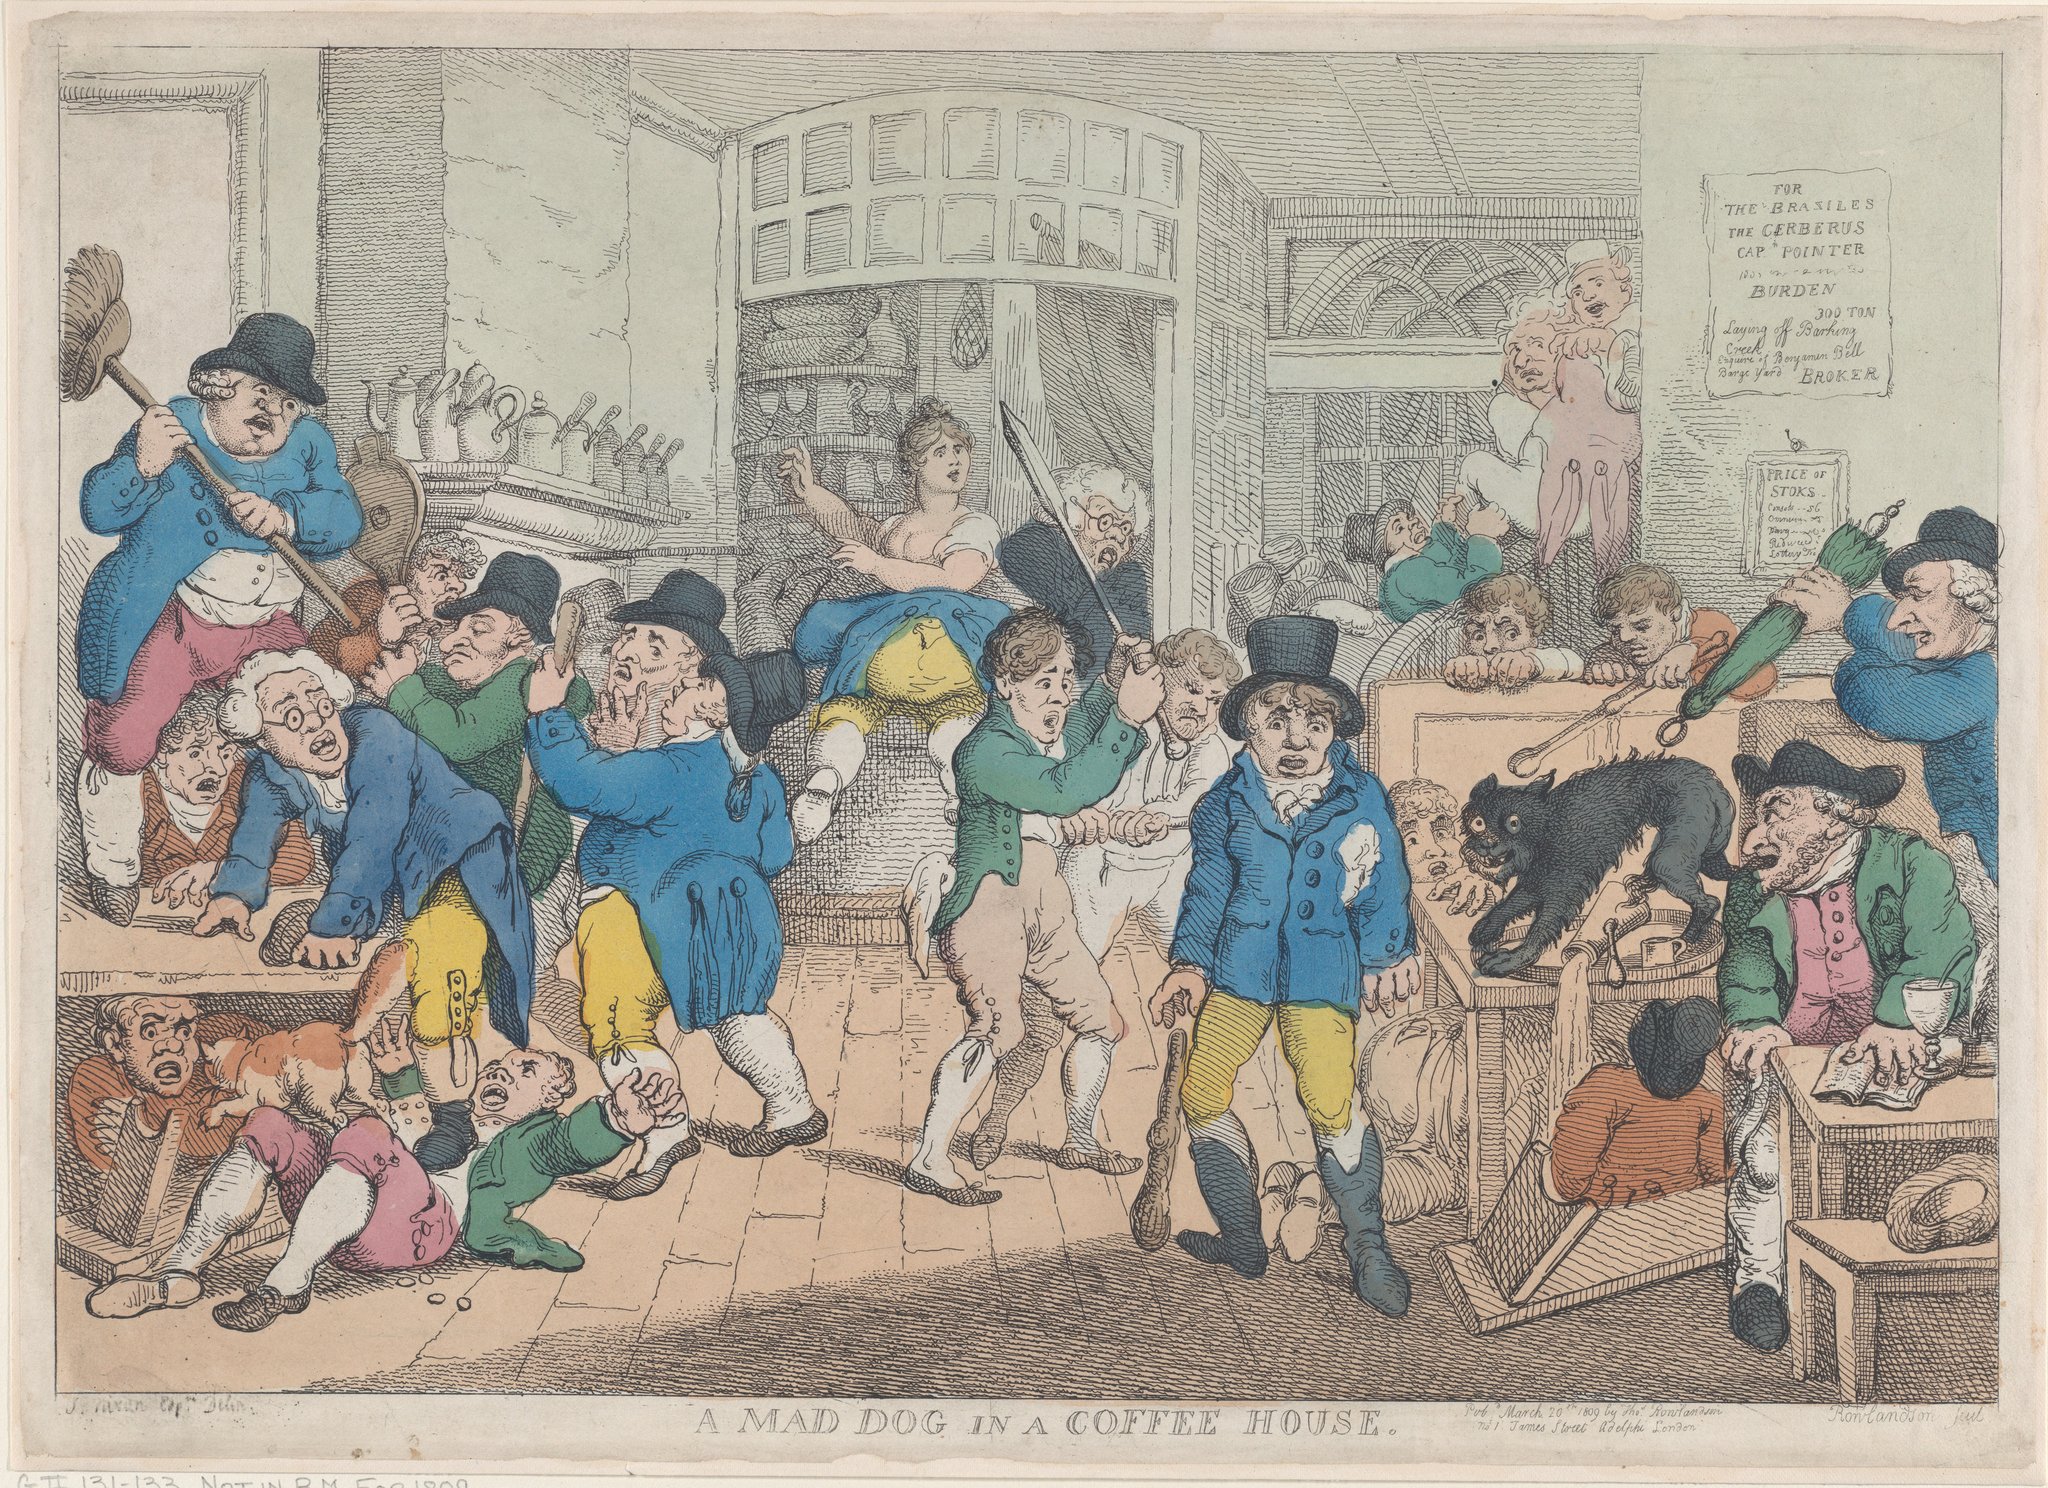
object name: print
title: A Mad Dog in a Coffee House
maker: thomas rowlandson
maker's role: artist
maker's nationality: british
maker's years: 1757-1827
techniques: etching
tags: satire,men,women,dogs